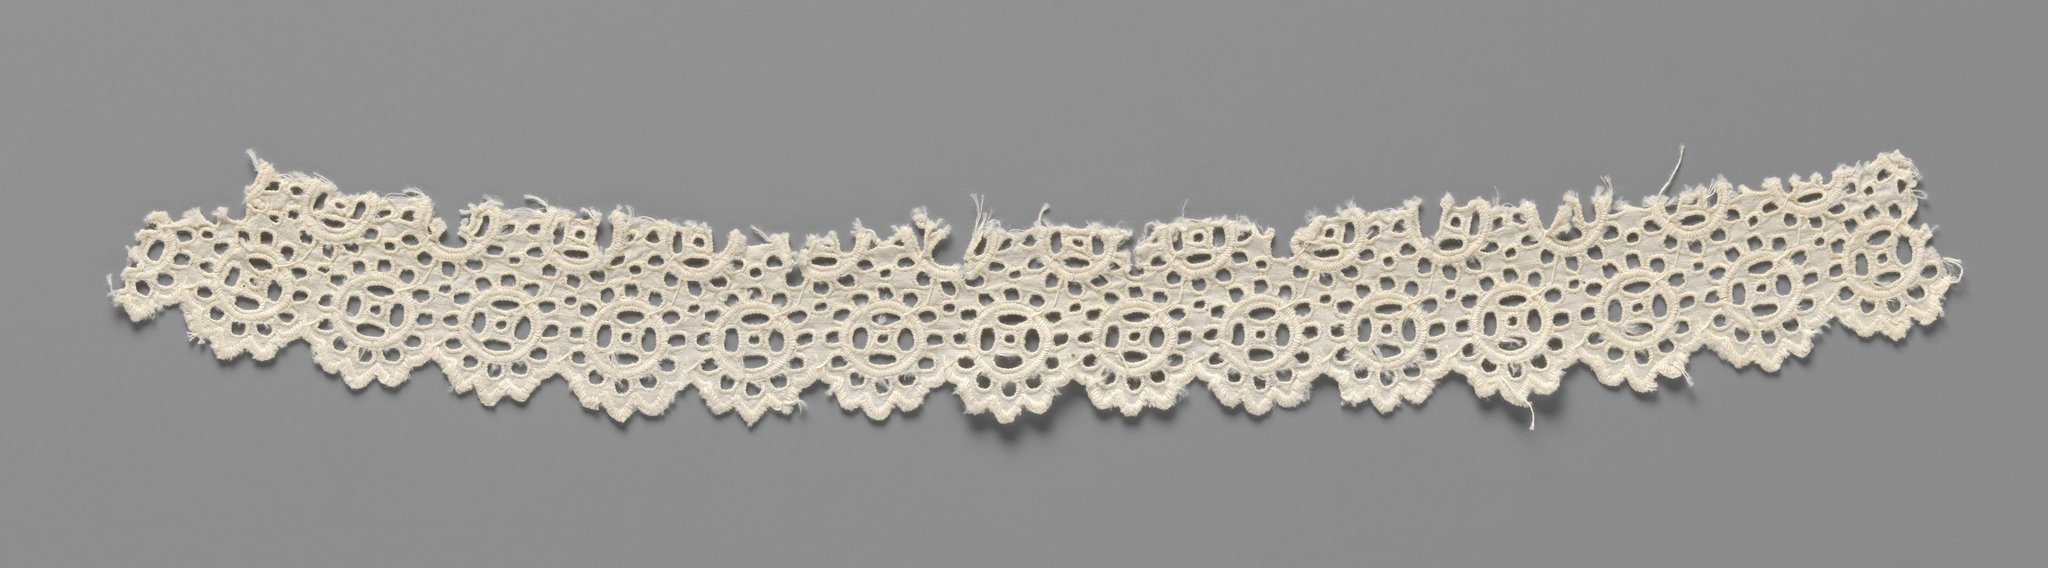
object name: strip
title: Strook katoen met Engels borduurwerk met een patroon van margrieten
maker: c.i. bosch reitz-teding van berkhout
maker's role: kantwerkster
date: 1860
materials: textile, cotton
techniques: weave, embroidery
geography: amsterdam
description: Strook naturelkleurig batist met kantborduurwerk: Engels borduurwerk. Het zich herhalende patroon uit twee rijen aaneengesloten opengewerkte margrieten, de rijen verspringen en rondom de onderste bloemen zijn schulpen gemaakt, met vijf geborduurde lobjes per schulp. De strook is in de lengte afgeknipt, halverwege door het patroon van de bovenste rij margrieten heen. Het batist is niet afgewerkt aan de lange en korte zijden.